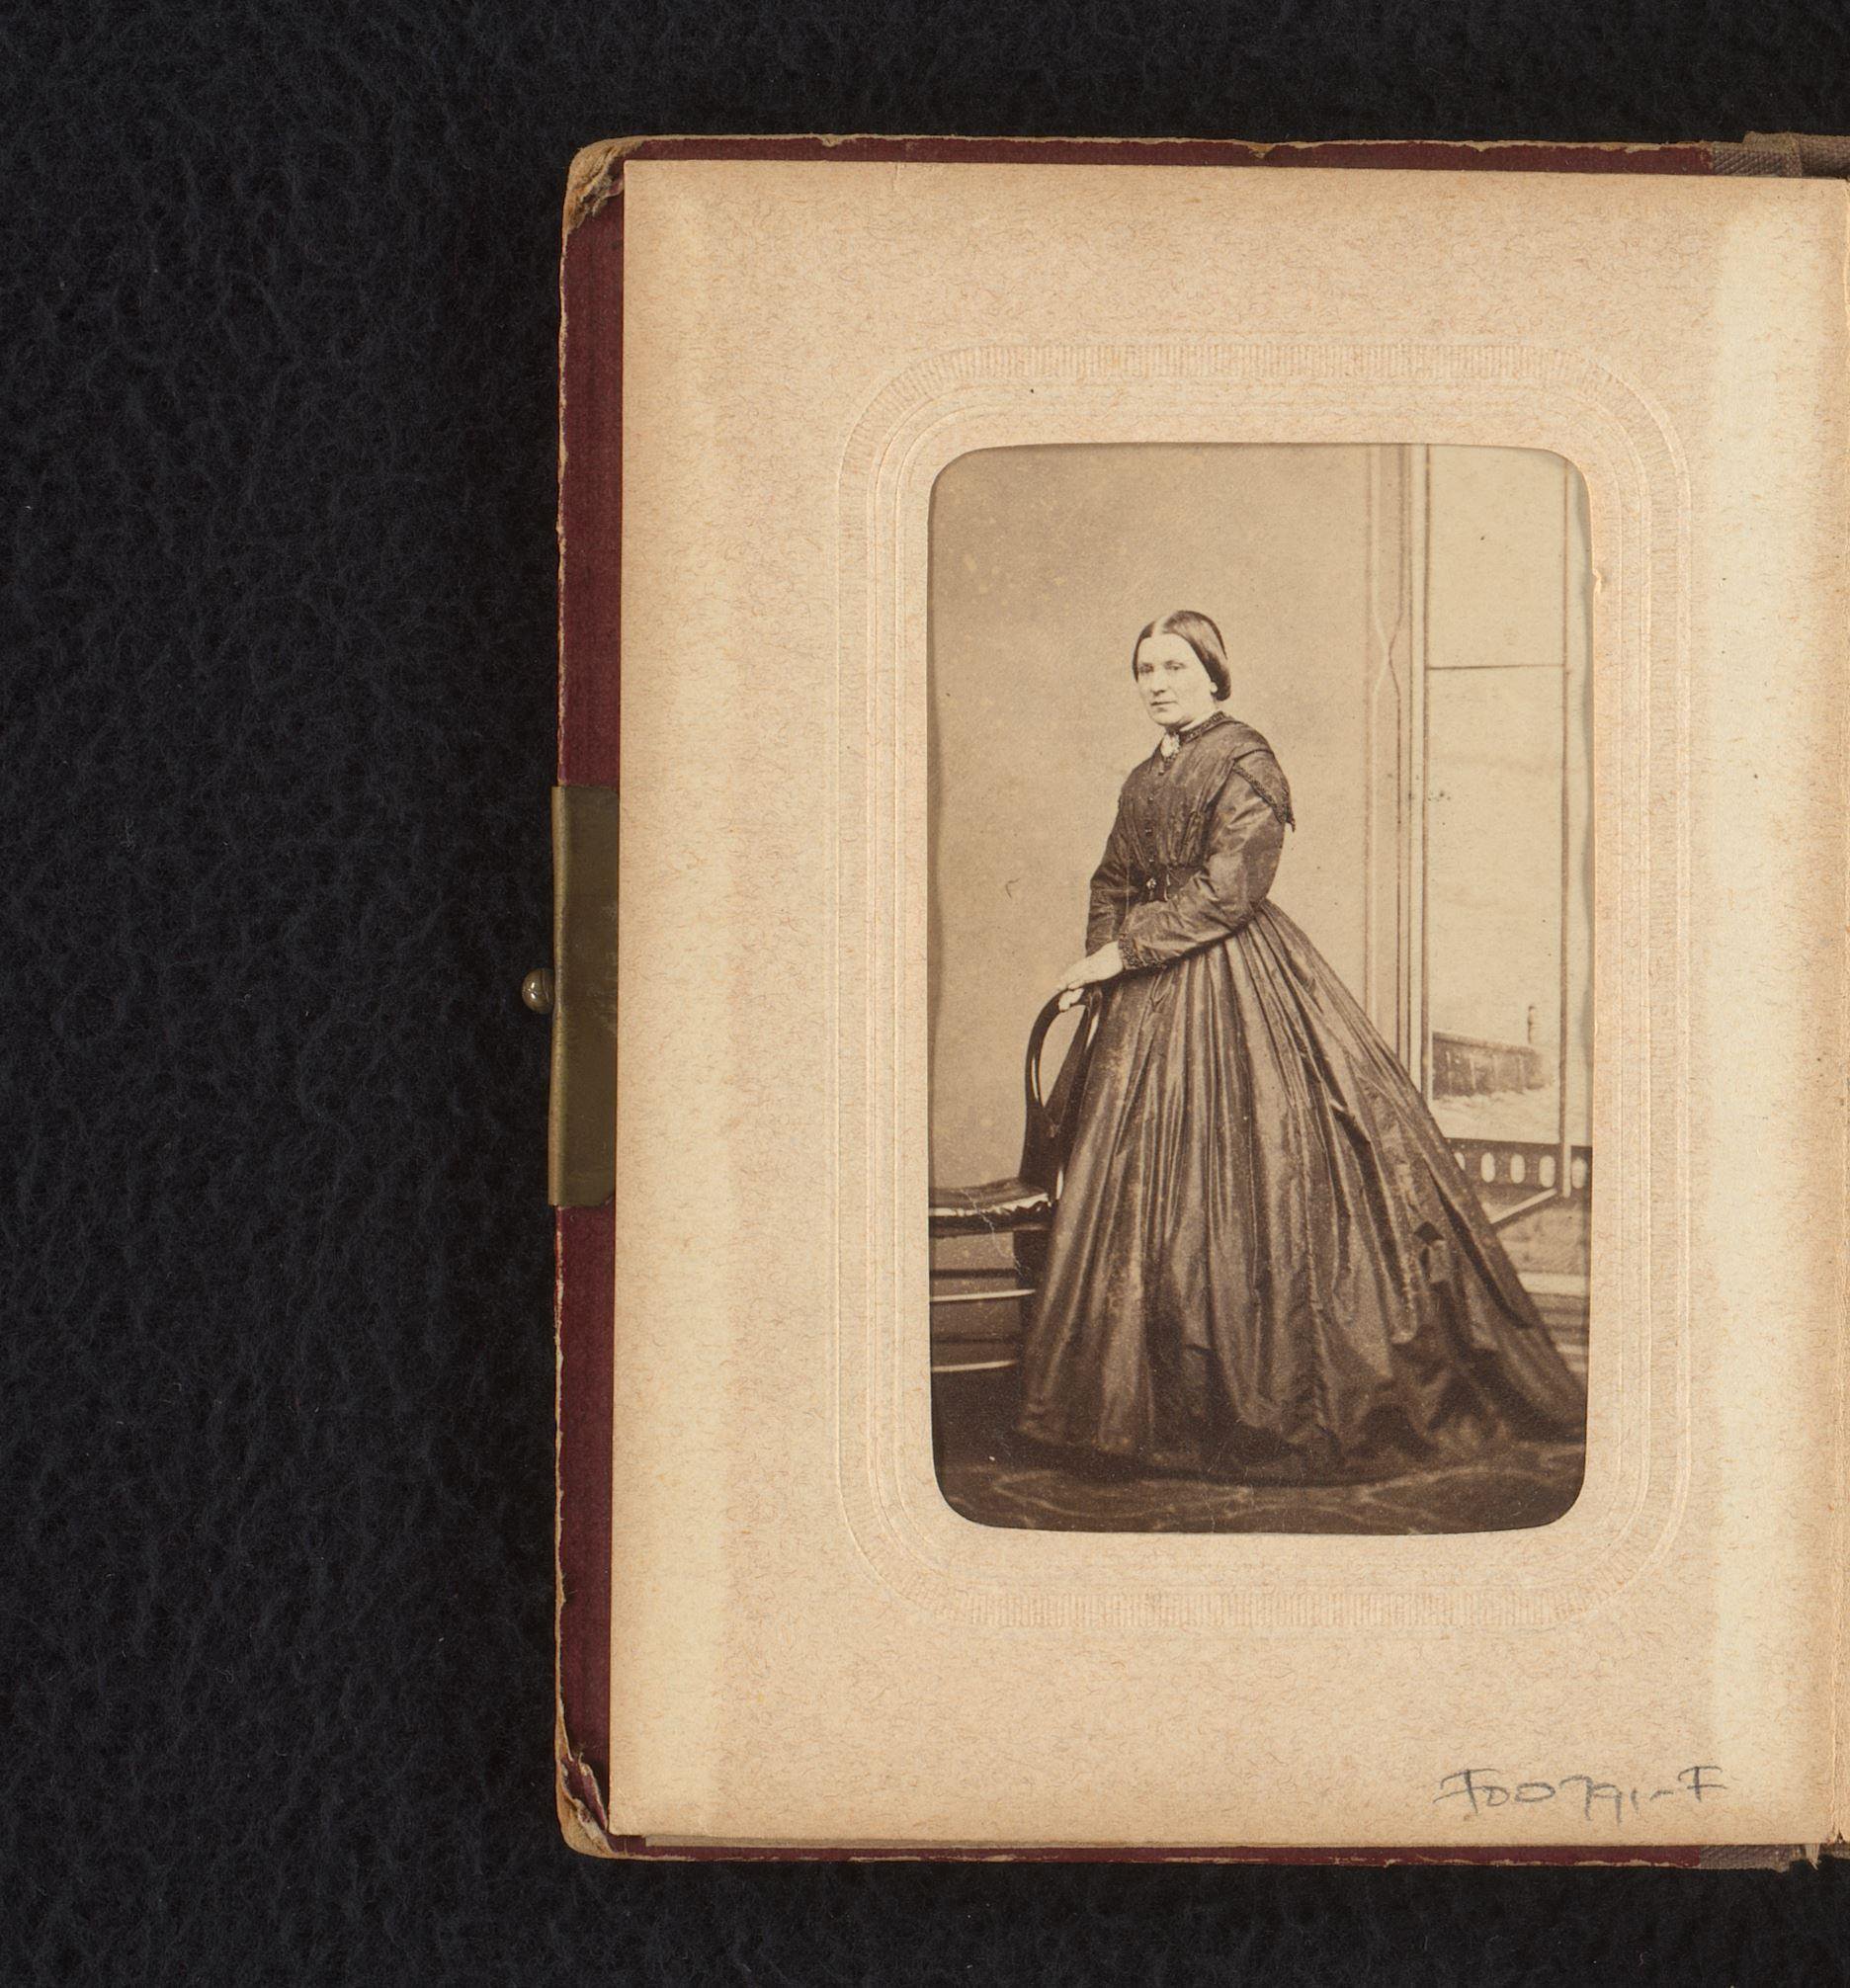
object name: album leaf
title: Portret van een staande vrouw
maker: west (fotograaf)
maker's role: fotograaf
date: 1860-1870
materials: cardboard, photographic support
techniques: albumen print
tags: historical persons, standing figure - aa - female human figure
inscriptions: inscription: ‘West/ Photographic Artist/ 60, High Street/ Gosport’